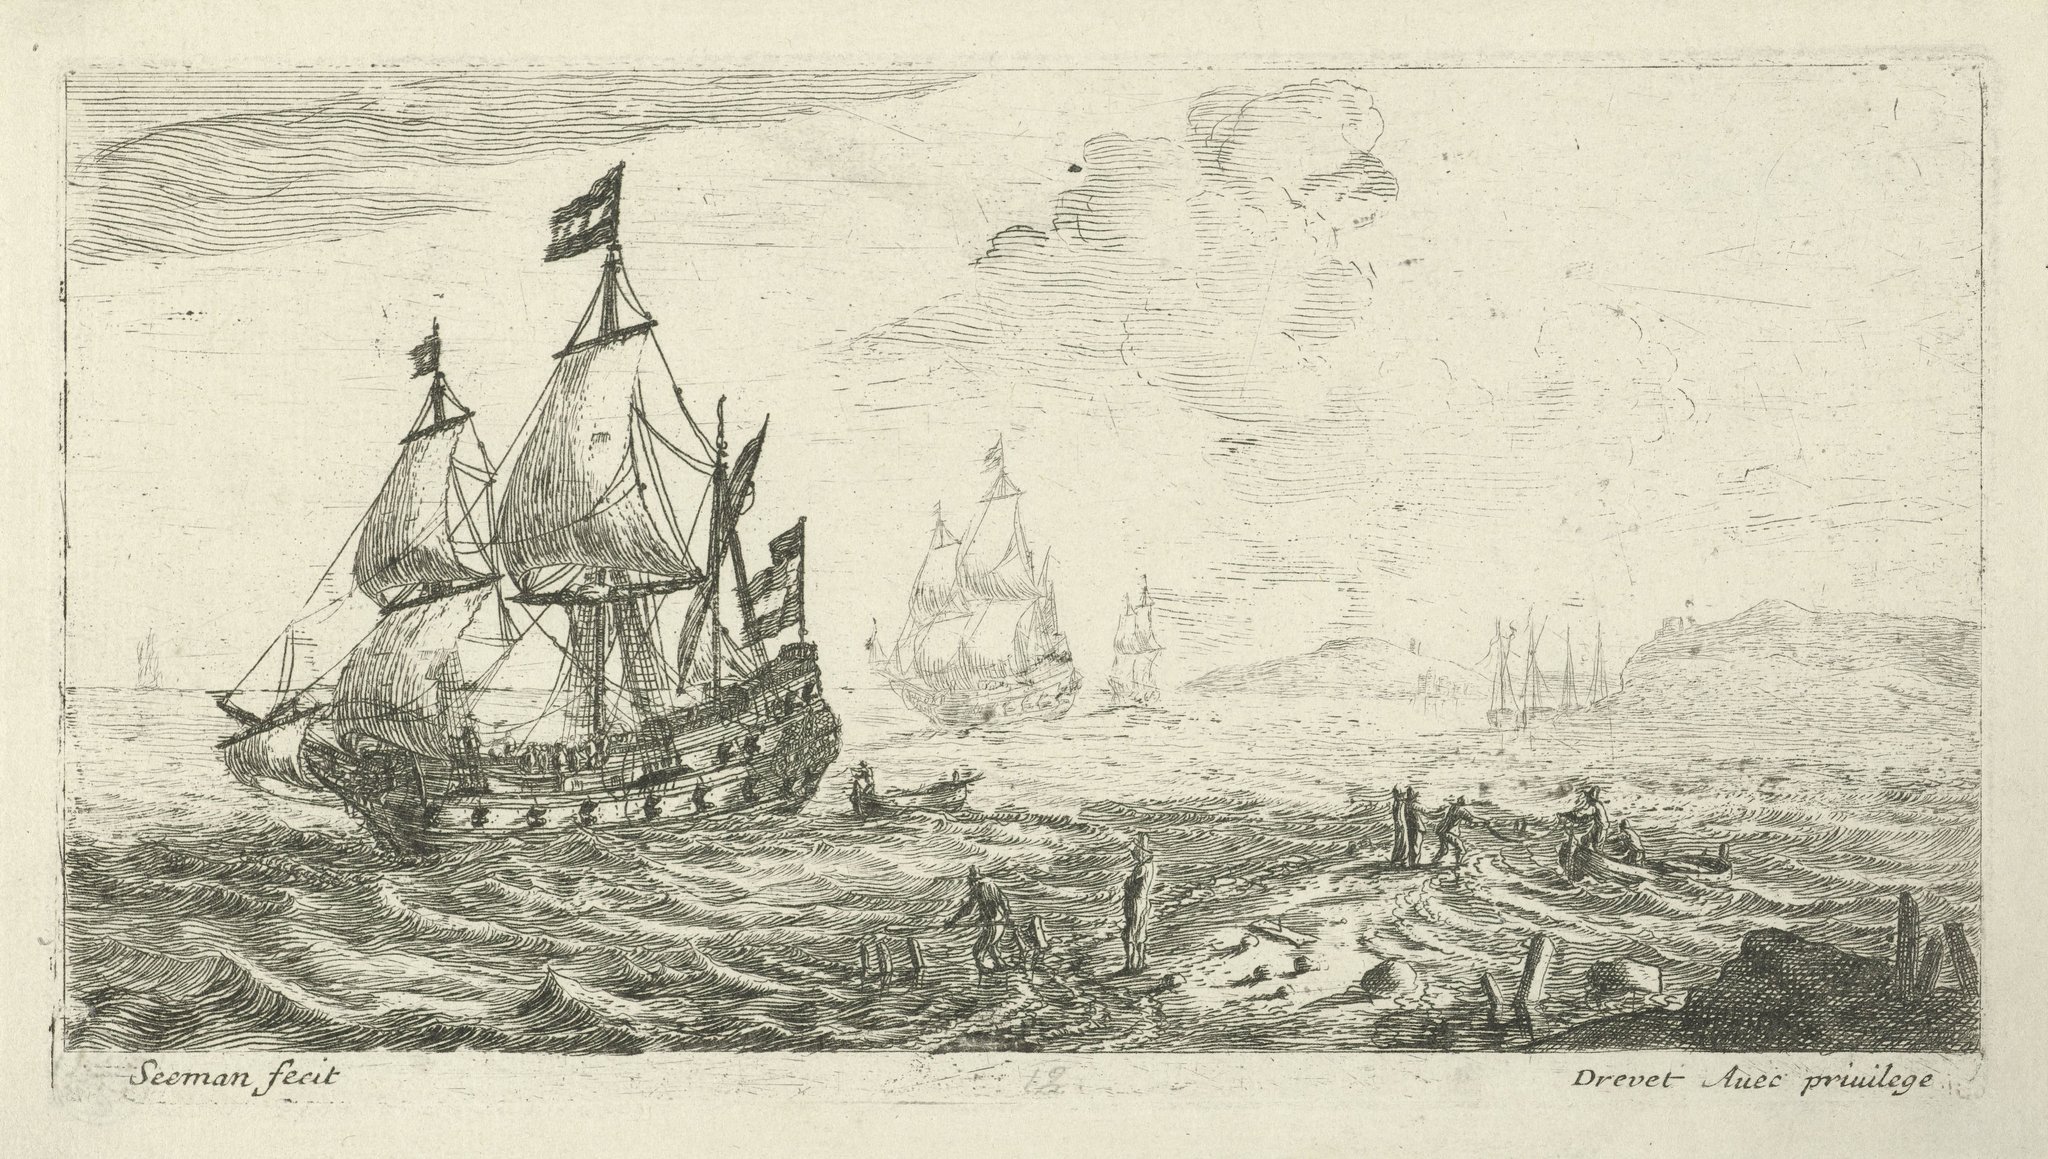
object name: print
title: Verschillende zeegezichten en landschappen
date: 1650-1738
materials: paper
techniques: etching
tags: sailing-ship, sailing-boat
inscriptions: collector's mark: Lugt 2228a, collector's mark: Lugt 1020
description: Drie grote zeilschepen, met de nederlandse vlag, voor de kust.